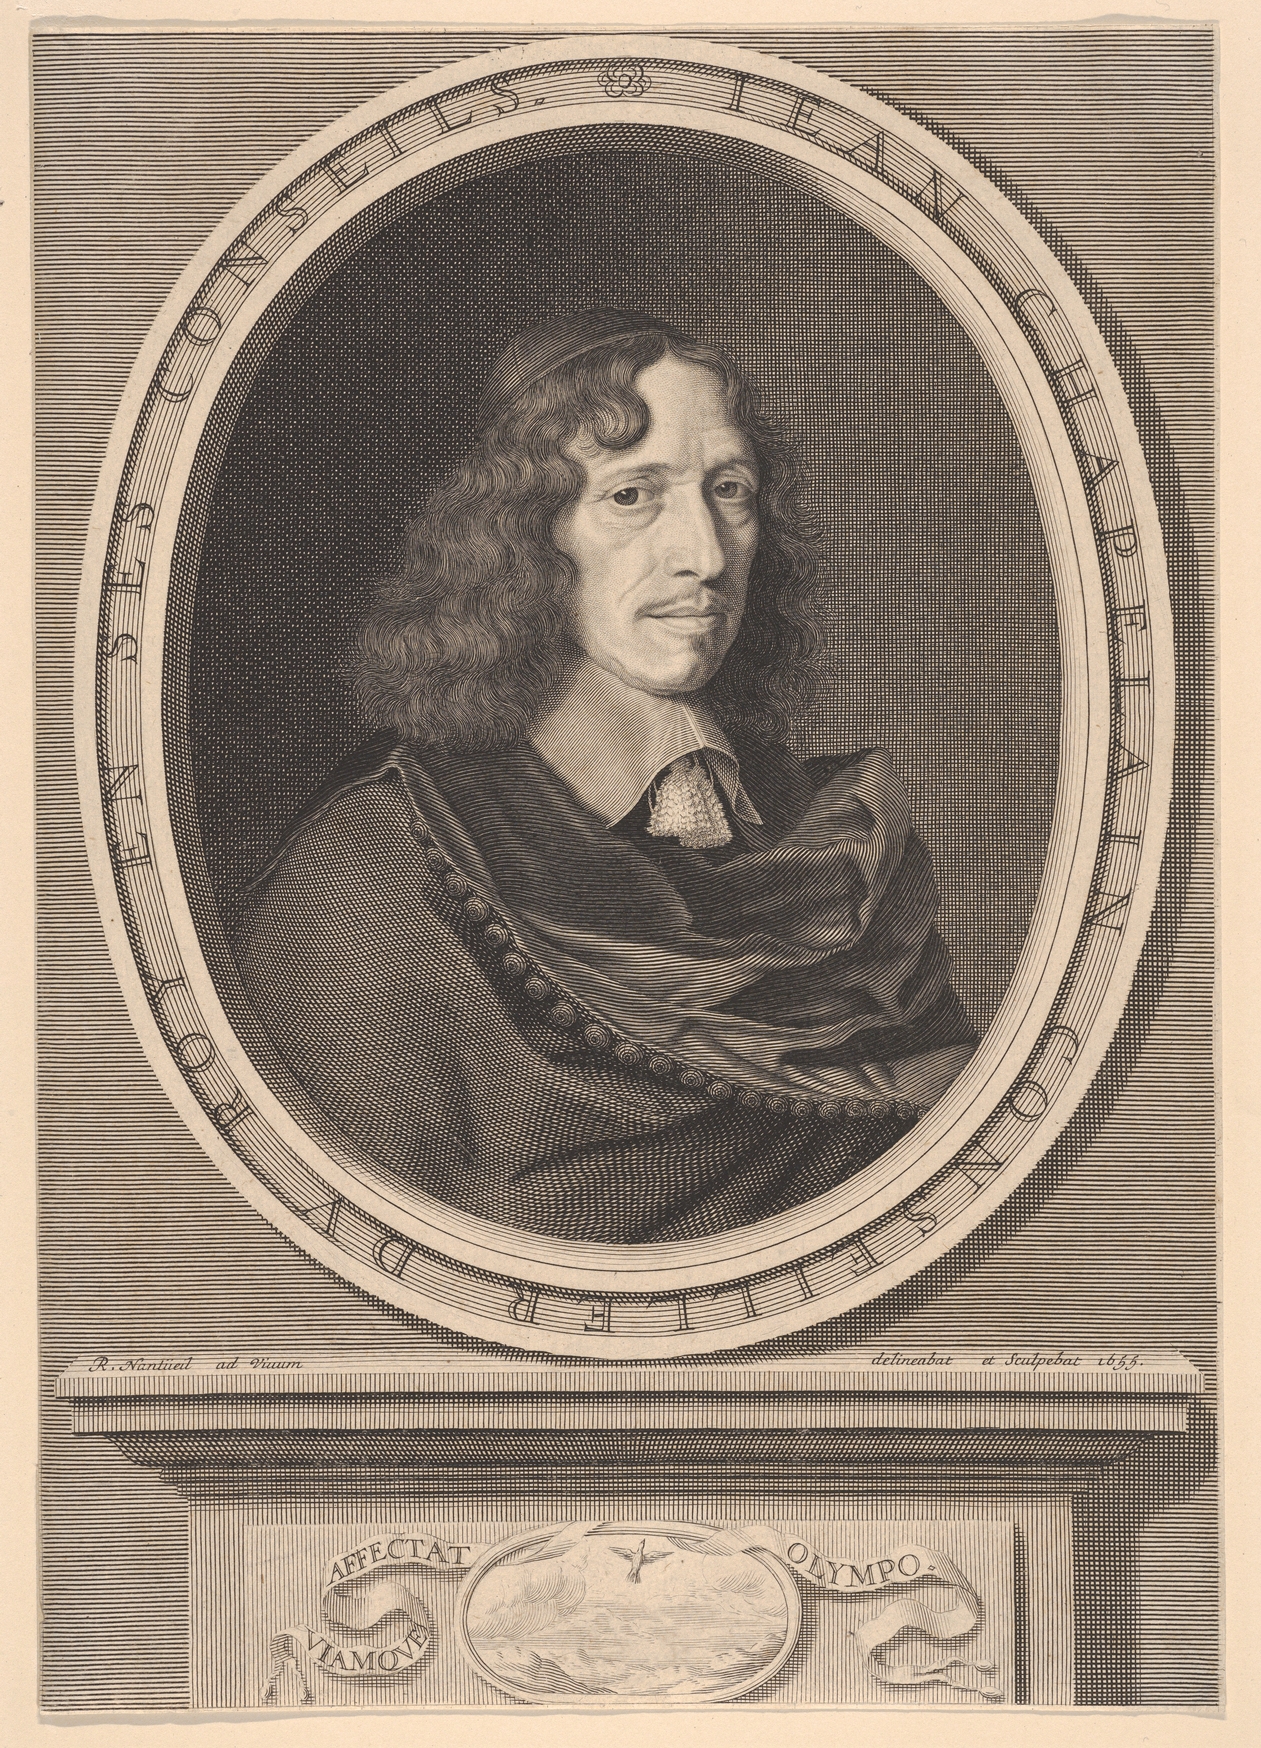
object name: print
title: Jean Champlain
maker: robert nanteuil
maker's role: artist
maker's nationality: french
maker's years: 1623-1678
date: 1655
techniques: engraving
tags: men,portraits